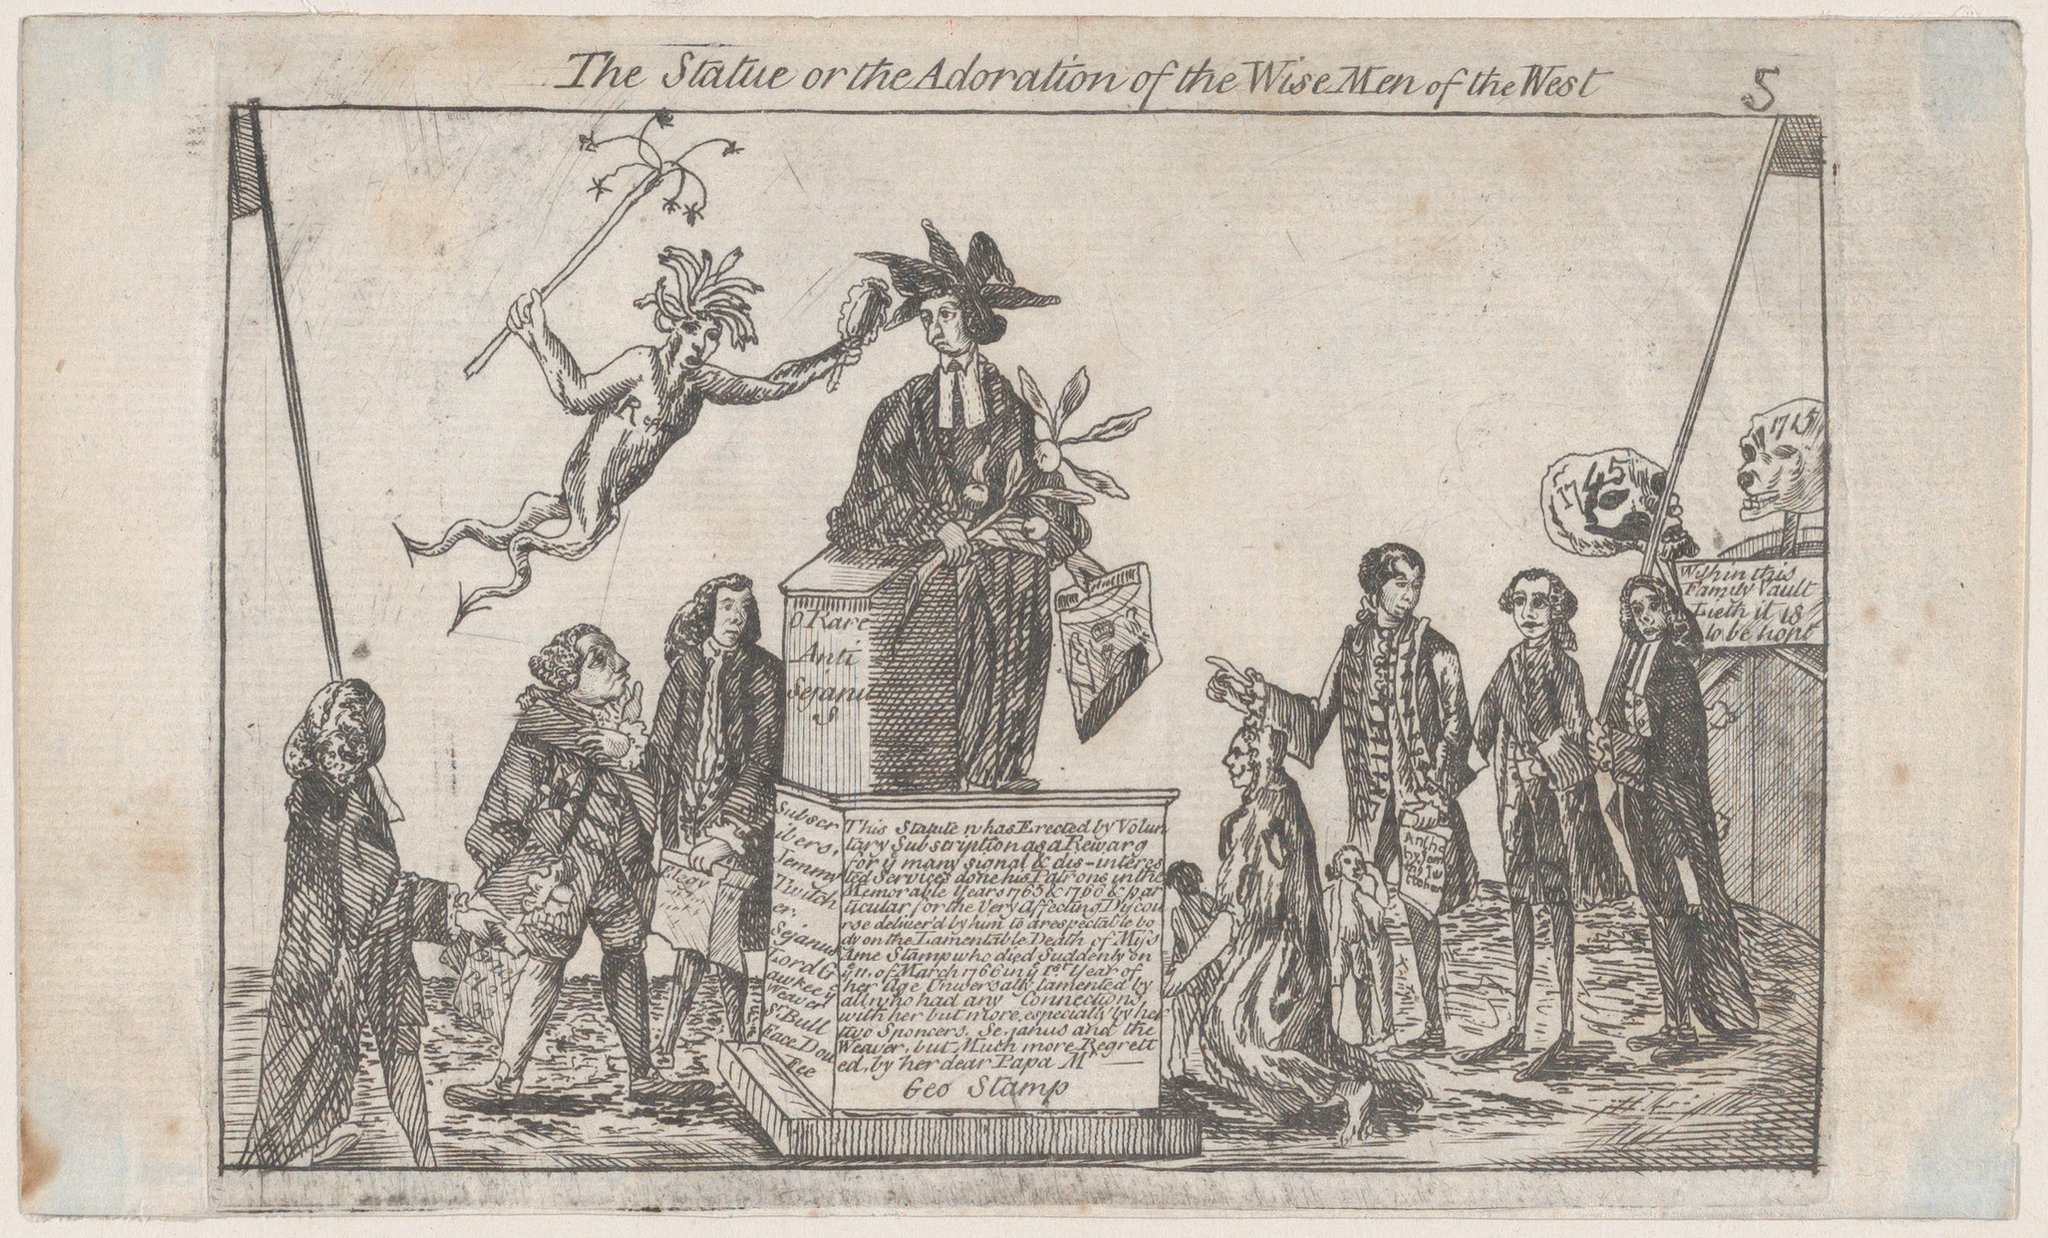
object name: print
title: The Statue, or the Adoration of the Wise Men of the West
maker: anonymous, british, 18th century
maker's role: artist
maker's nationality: british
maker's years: 1700-1800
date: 1766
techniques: etching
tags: satire,american revolution,men